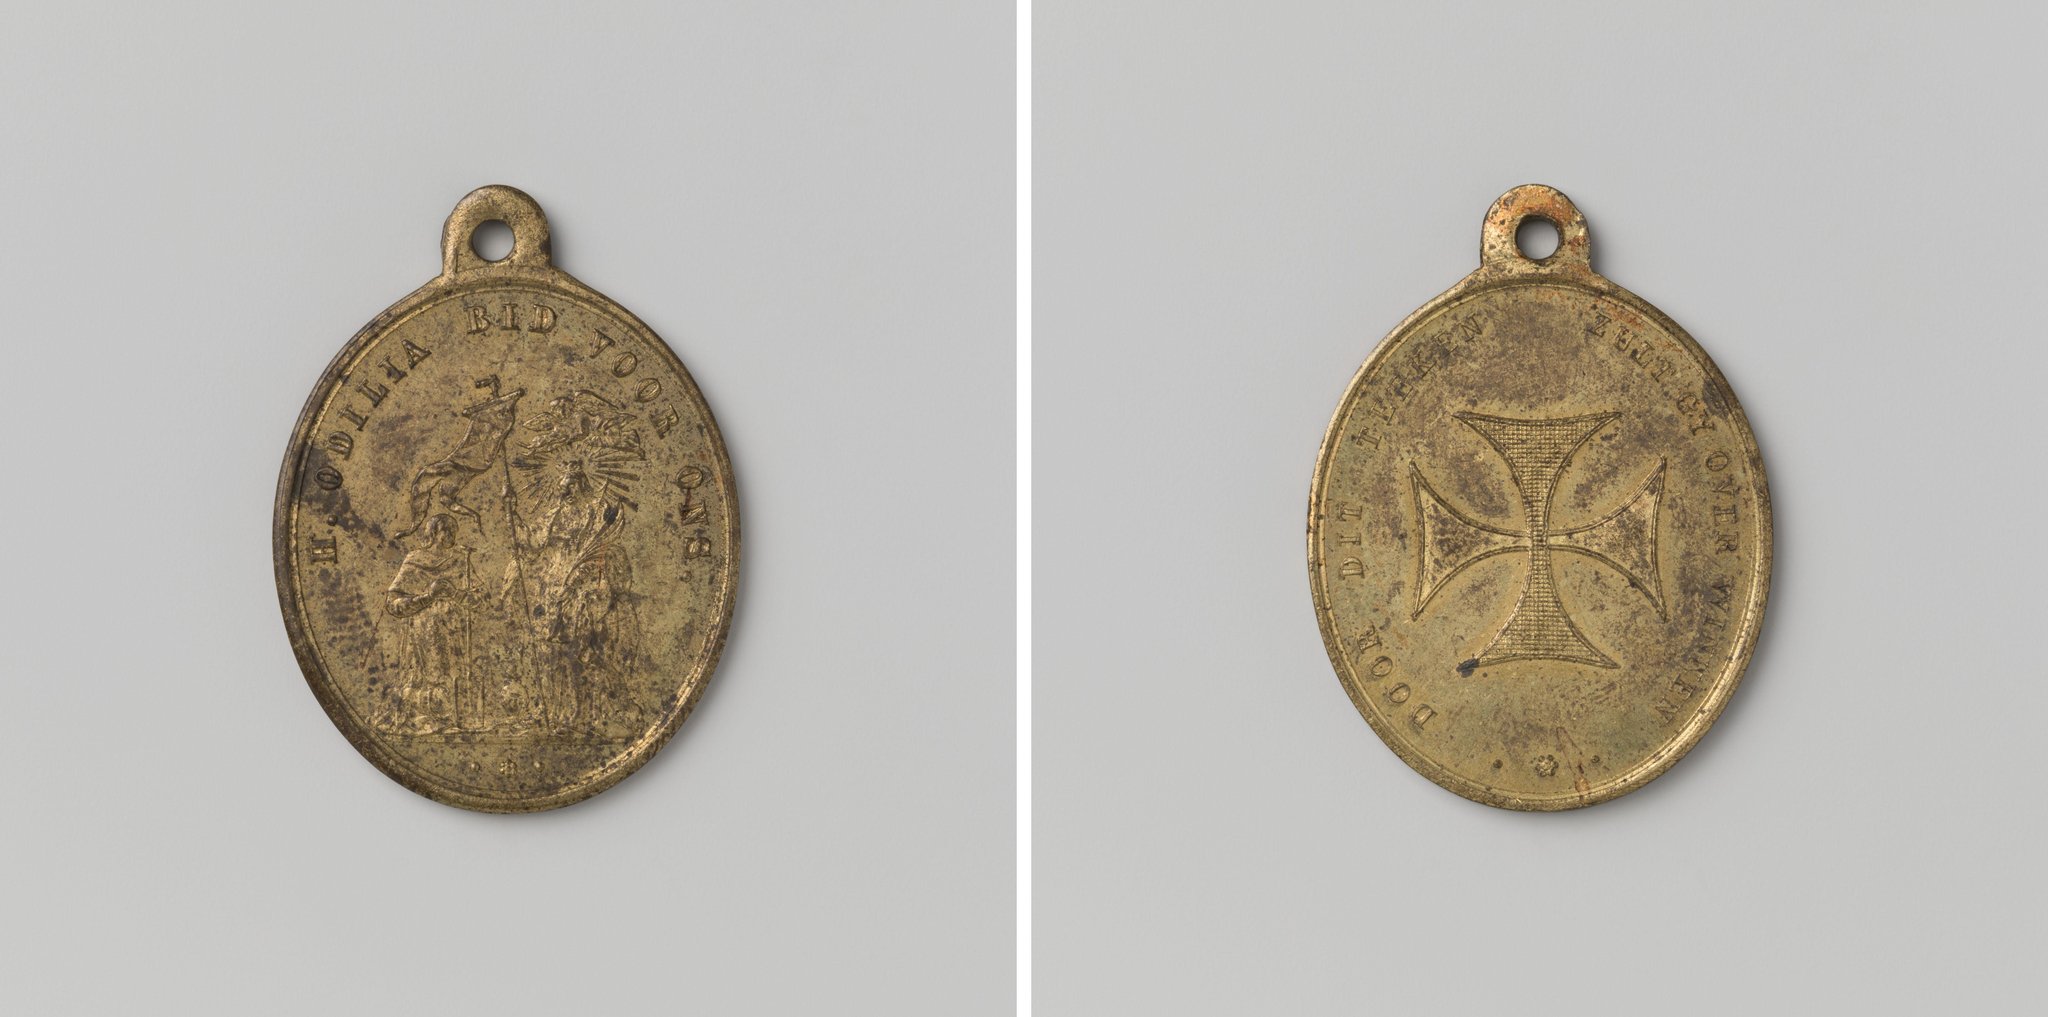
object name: devotional medal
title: Heilige Odilia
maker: Anonymous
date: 1800-1850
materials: brass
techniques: striking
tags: the alsatian royal abbess odilia of hohenburg; possible attributes: baptismal font, cock, crown, eyes (on book or dish)